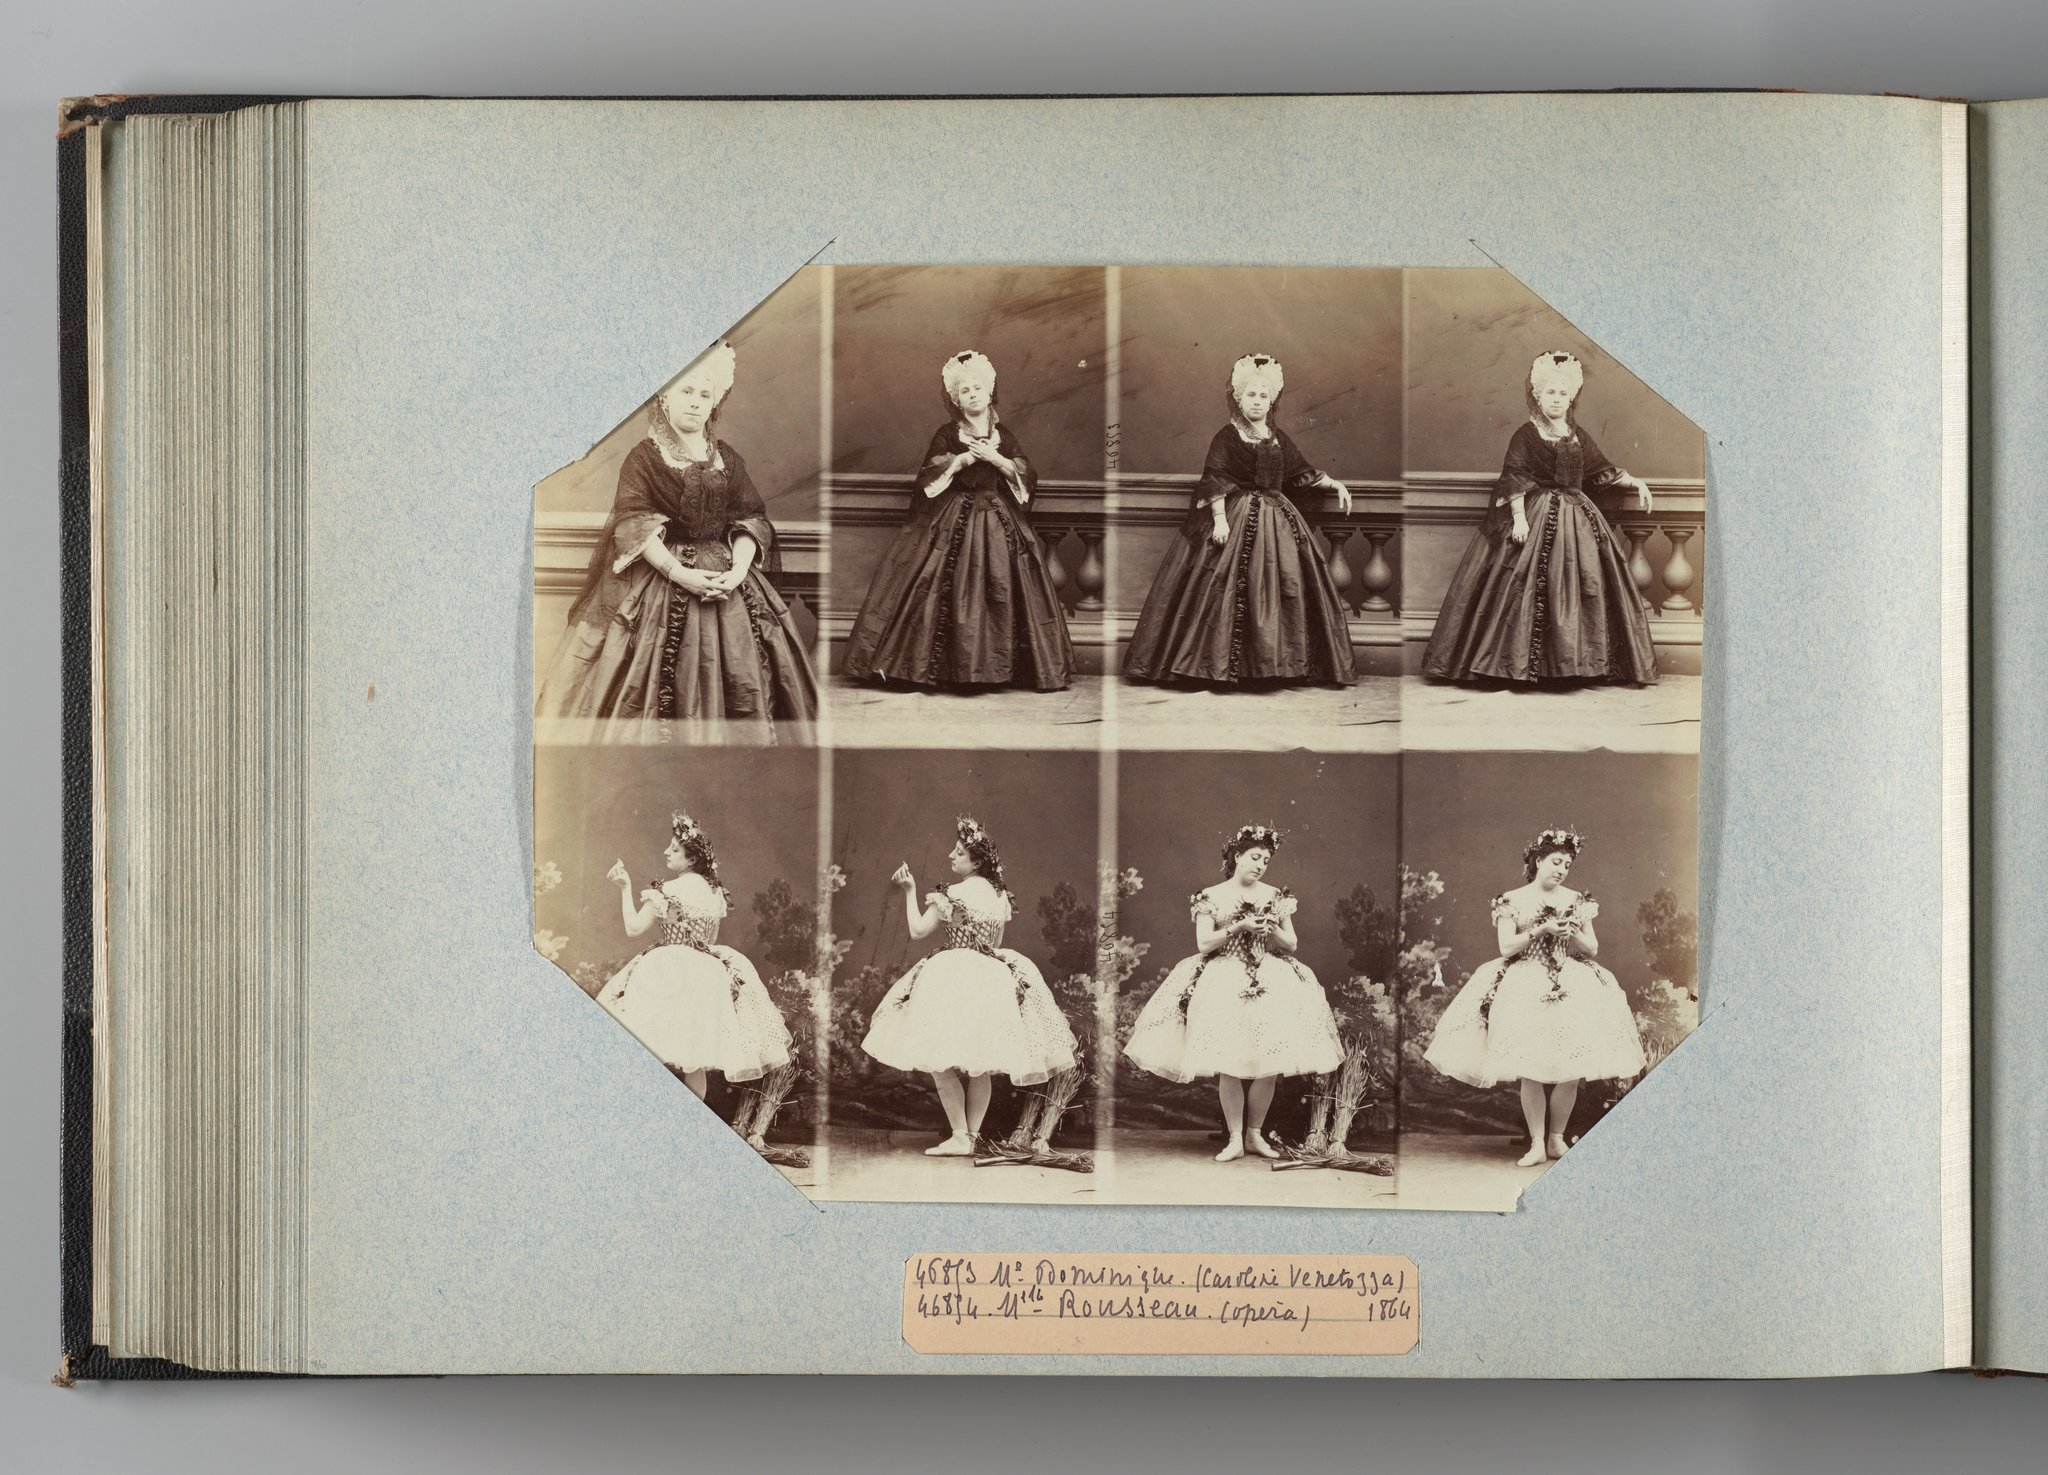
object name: photograph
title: Mlle Dominique; Mlle Rousseau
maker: andré-adolphe-eugène disdéri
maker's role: artist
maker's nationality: french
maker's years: 1819-1889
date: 1864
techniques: albumen silver print, glass negative